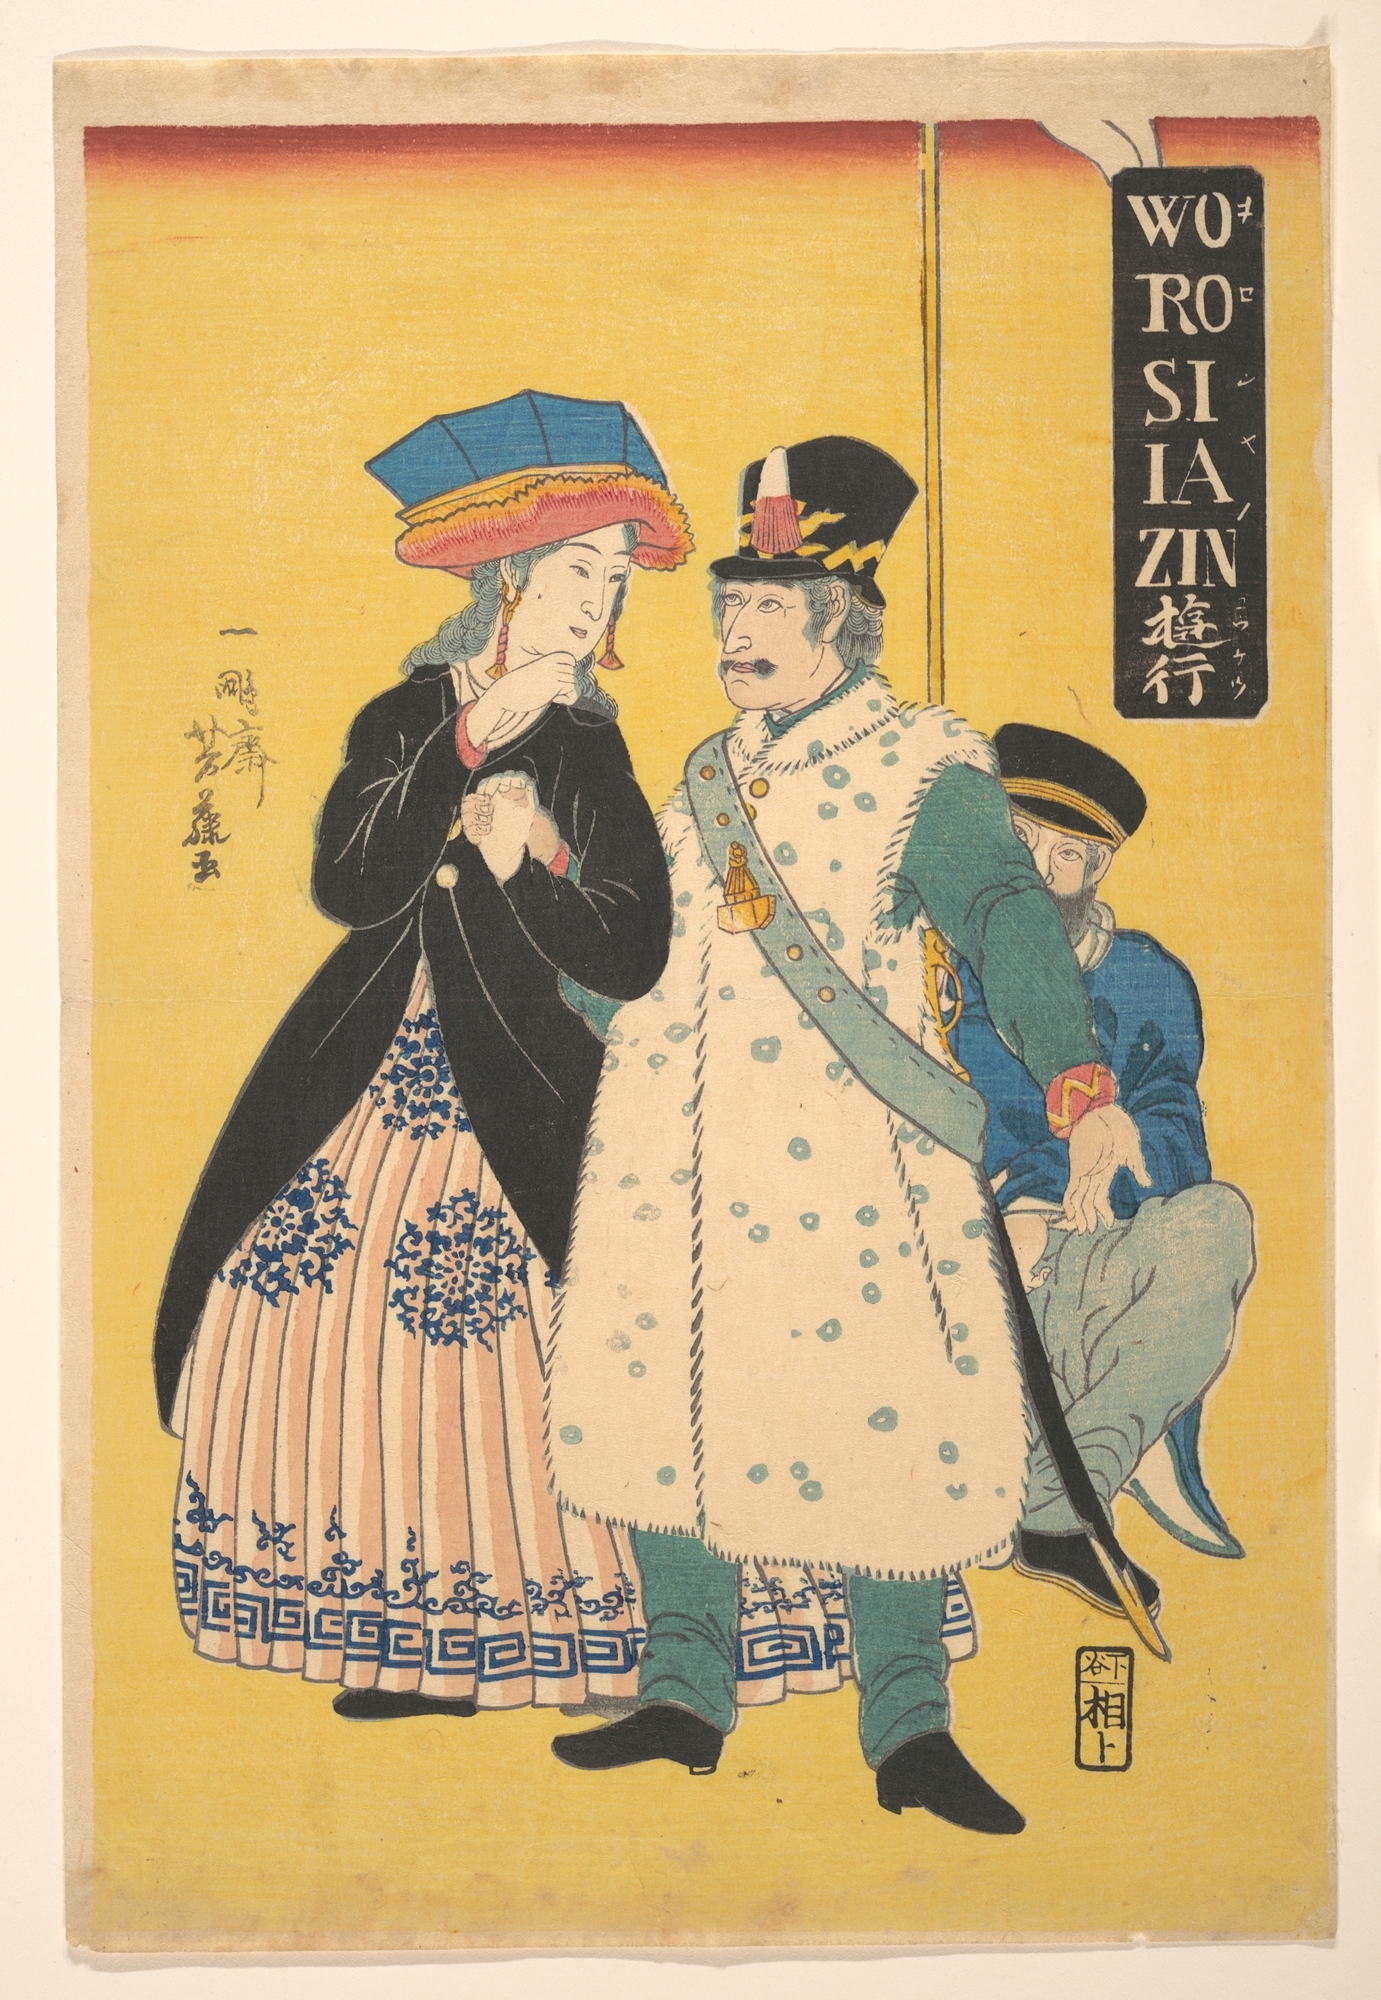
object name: print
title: Russian Soldier with His Family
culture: japanese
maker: ippōsai yoshifuji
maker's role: artist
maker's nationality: japanese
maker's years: 1828-1887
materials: ink, paper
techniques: woodblock print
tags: soldiers,swords,family